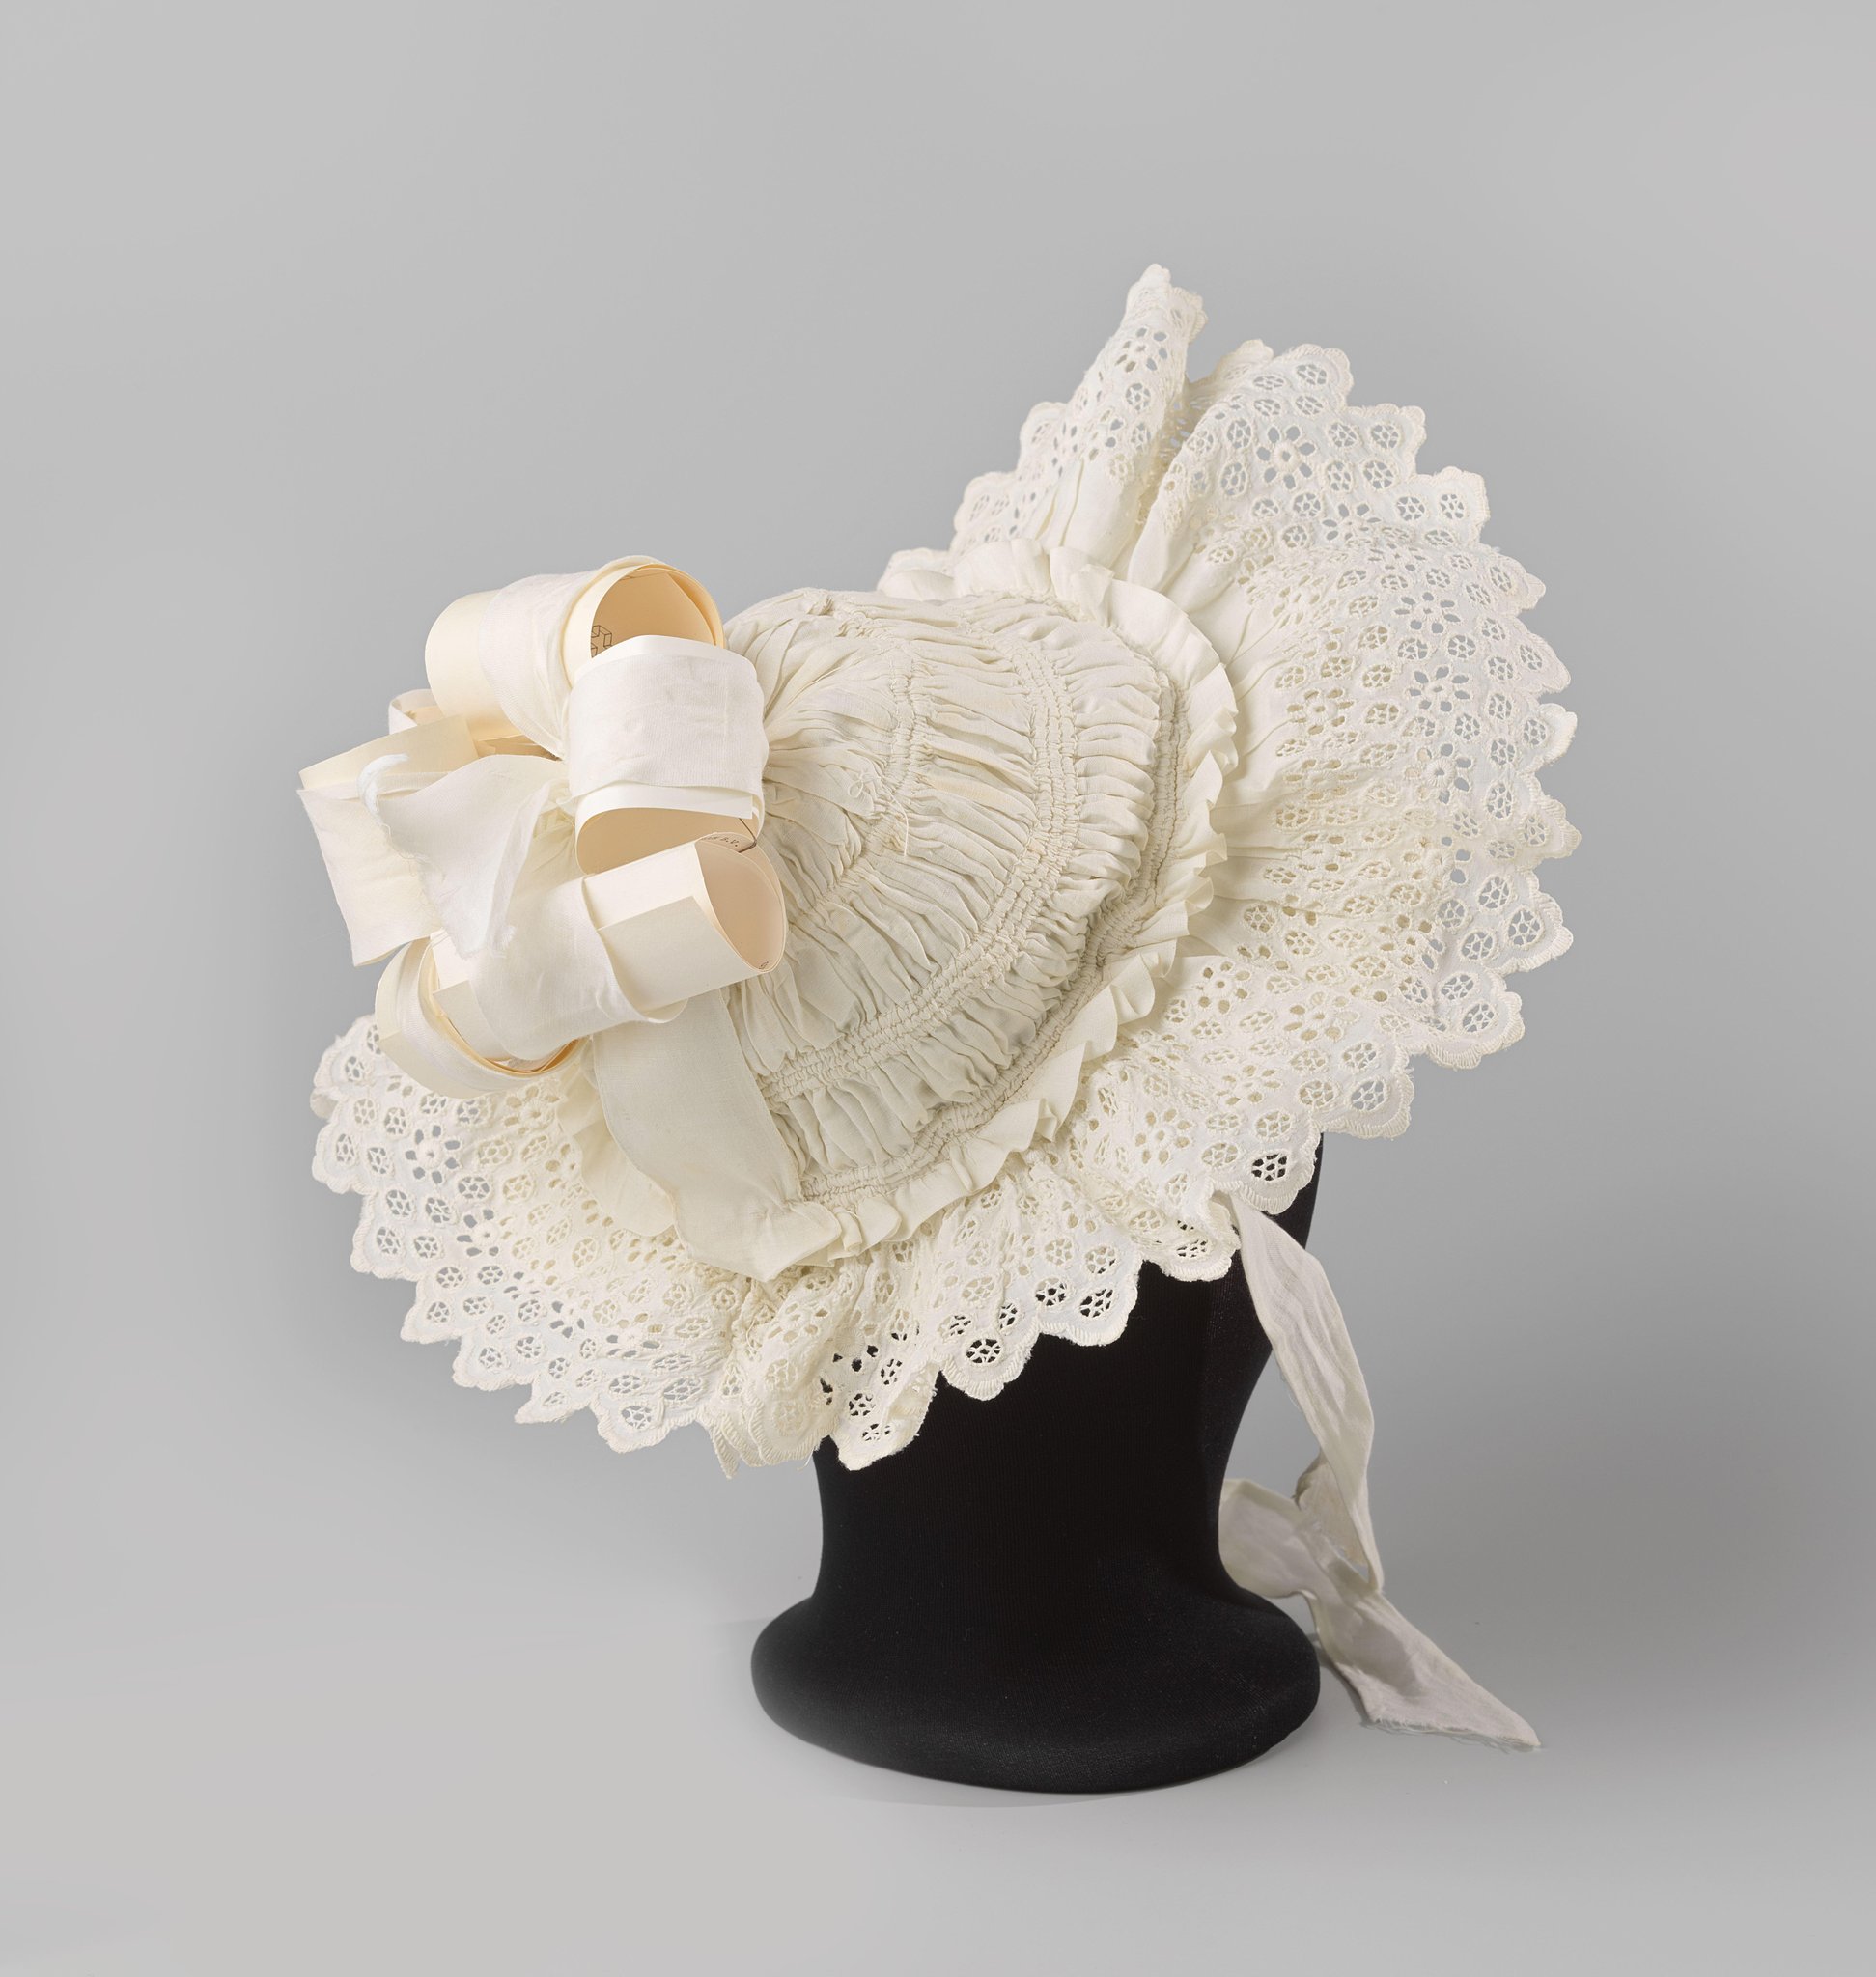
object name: zonnehoed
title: Kinderzonnehoed piqué met laiton gevulde inrimpelingen en met twee stroken Engels borduurwerk, versierd met een grote strik van achter en een kleine strik op de kruin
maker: Anonymous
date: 1890-1910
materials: textile, metal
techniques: english embroidery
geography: brussels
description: Kinderzonnehoed piqué met laiton gevulde inrimpelingen en met twee stroken Engels borduurwerk, versierd met een grote strik van achter en een kleine strik op de kruin. Model als een pillbox, met een brede, versierde ajourrand, waarin drie gerimpelde stiksels met karton verstevigd zijn. Aan de opstaande bol een vlakke bodem, waaraan een sterk ingerimpelde strook Engels borduurwerk. Kinnebanden van batist. Voeringbodem van mul. Borduurwerk van schubvormen, margrieten.